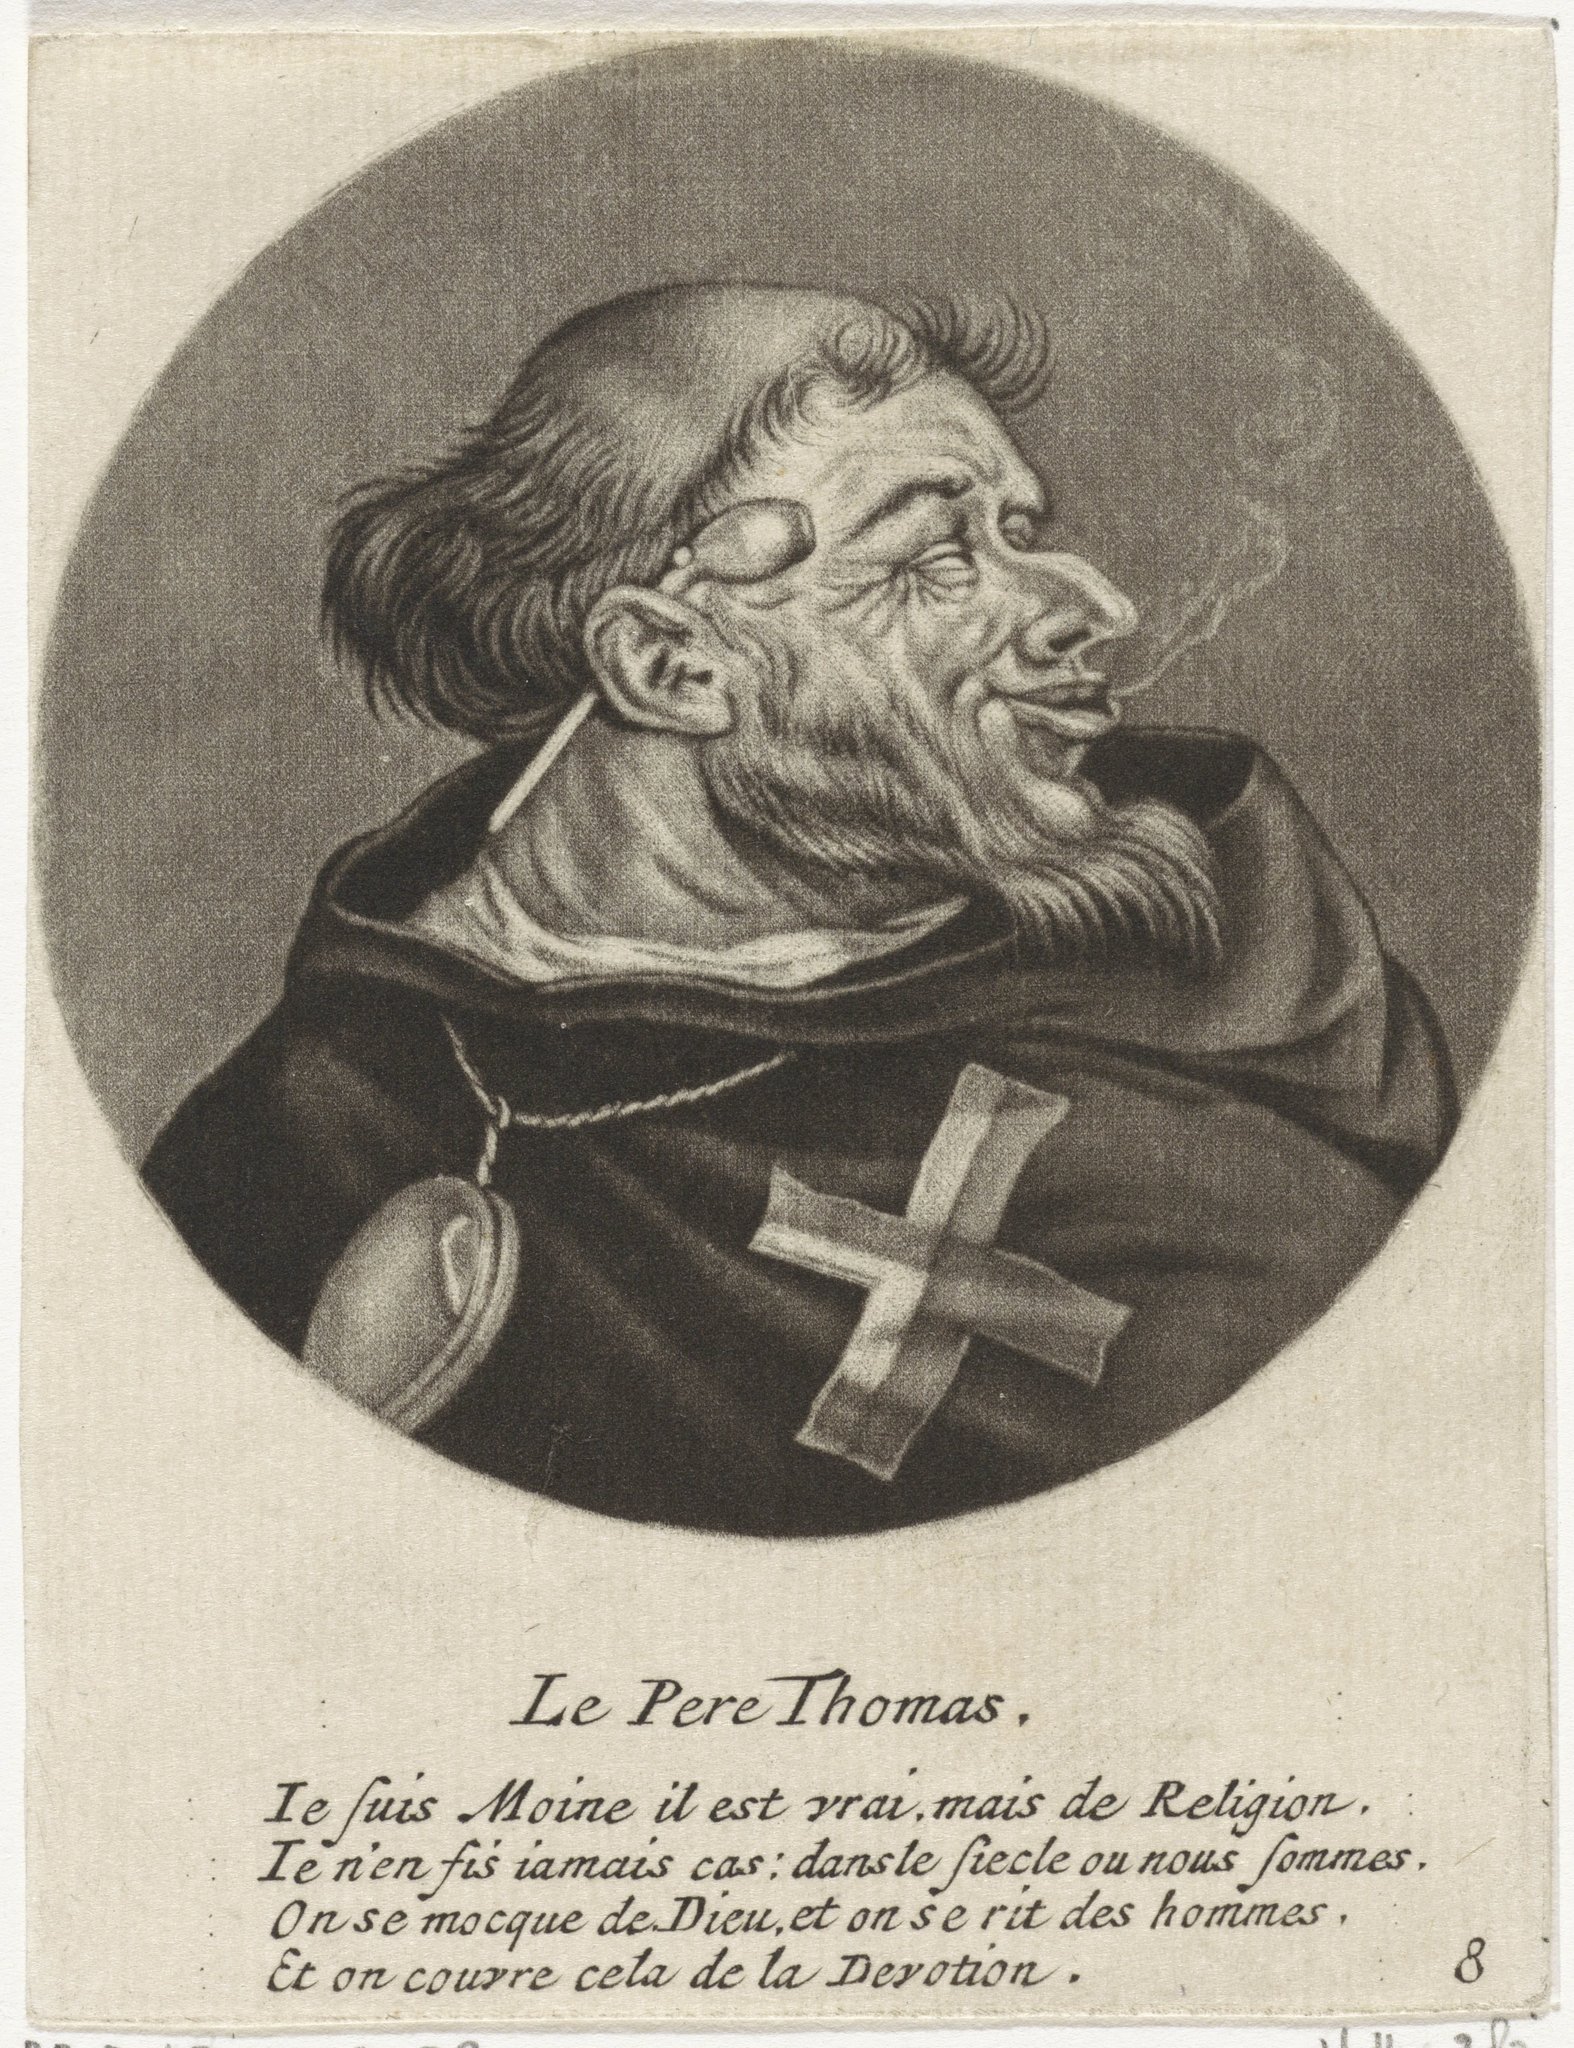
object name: print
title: Le Pere Thomas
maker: jacob gole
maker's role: print maker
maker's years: 1660-1724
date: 1670-1724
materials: paper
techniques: engraving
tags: pipe ~ tobacco, monk(s), friar(s), political caricatures and satires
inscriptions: collector's mark: Lugt 2228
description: De prent verscheen in de bundel "Renversement de la Morale Chrétienne par les désordres du Monachisme". Volgens Wiebke Schmoldt (1997) verscheen deze bundel tussen 1693 en 1700.